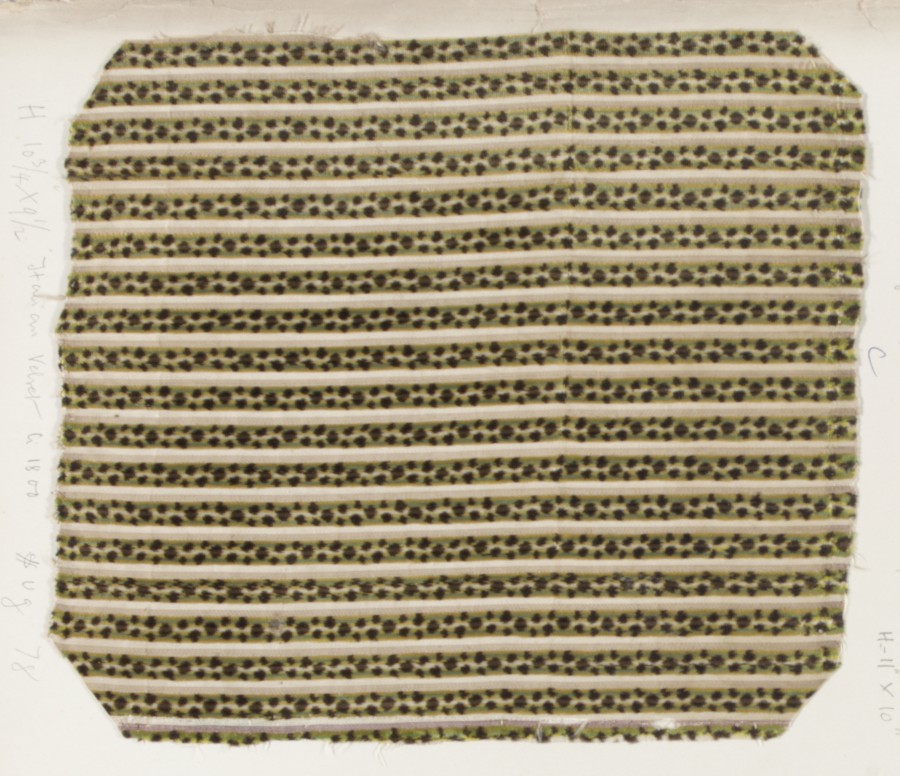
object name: fragment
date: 1800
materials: silk